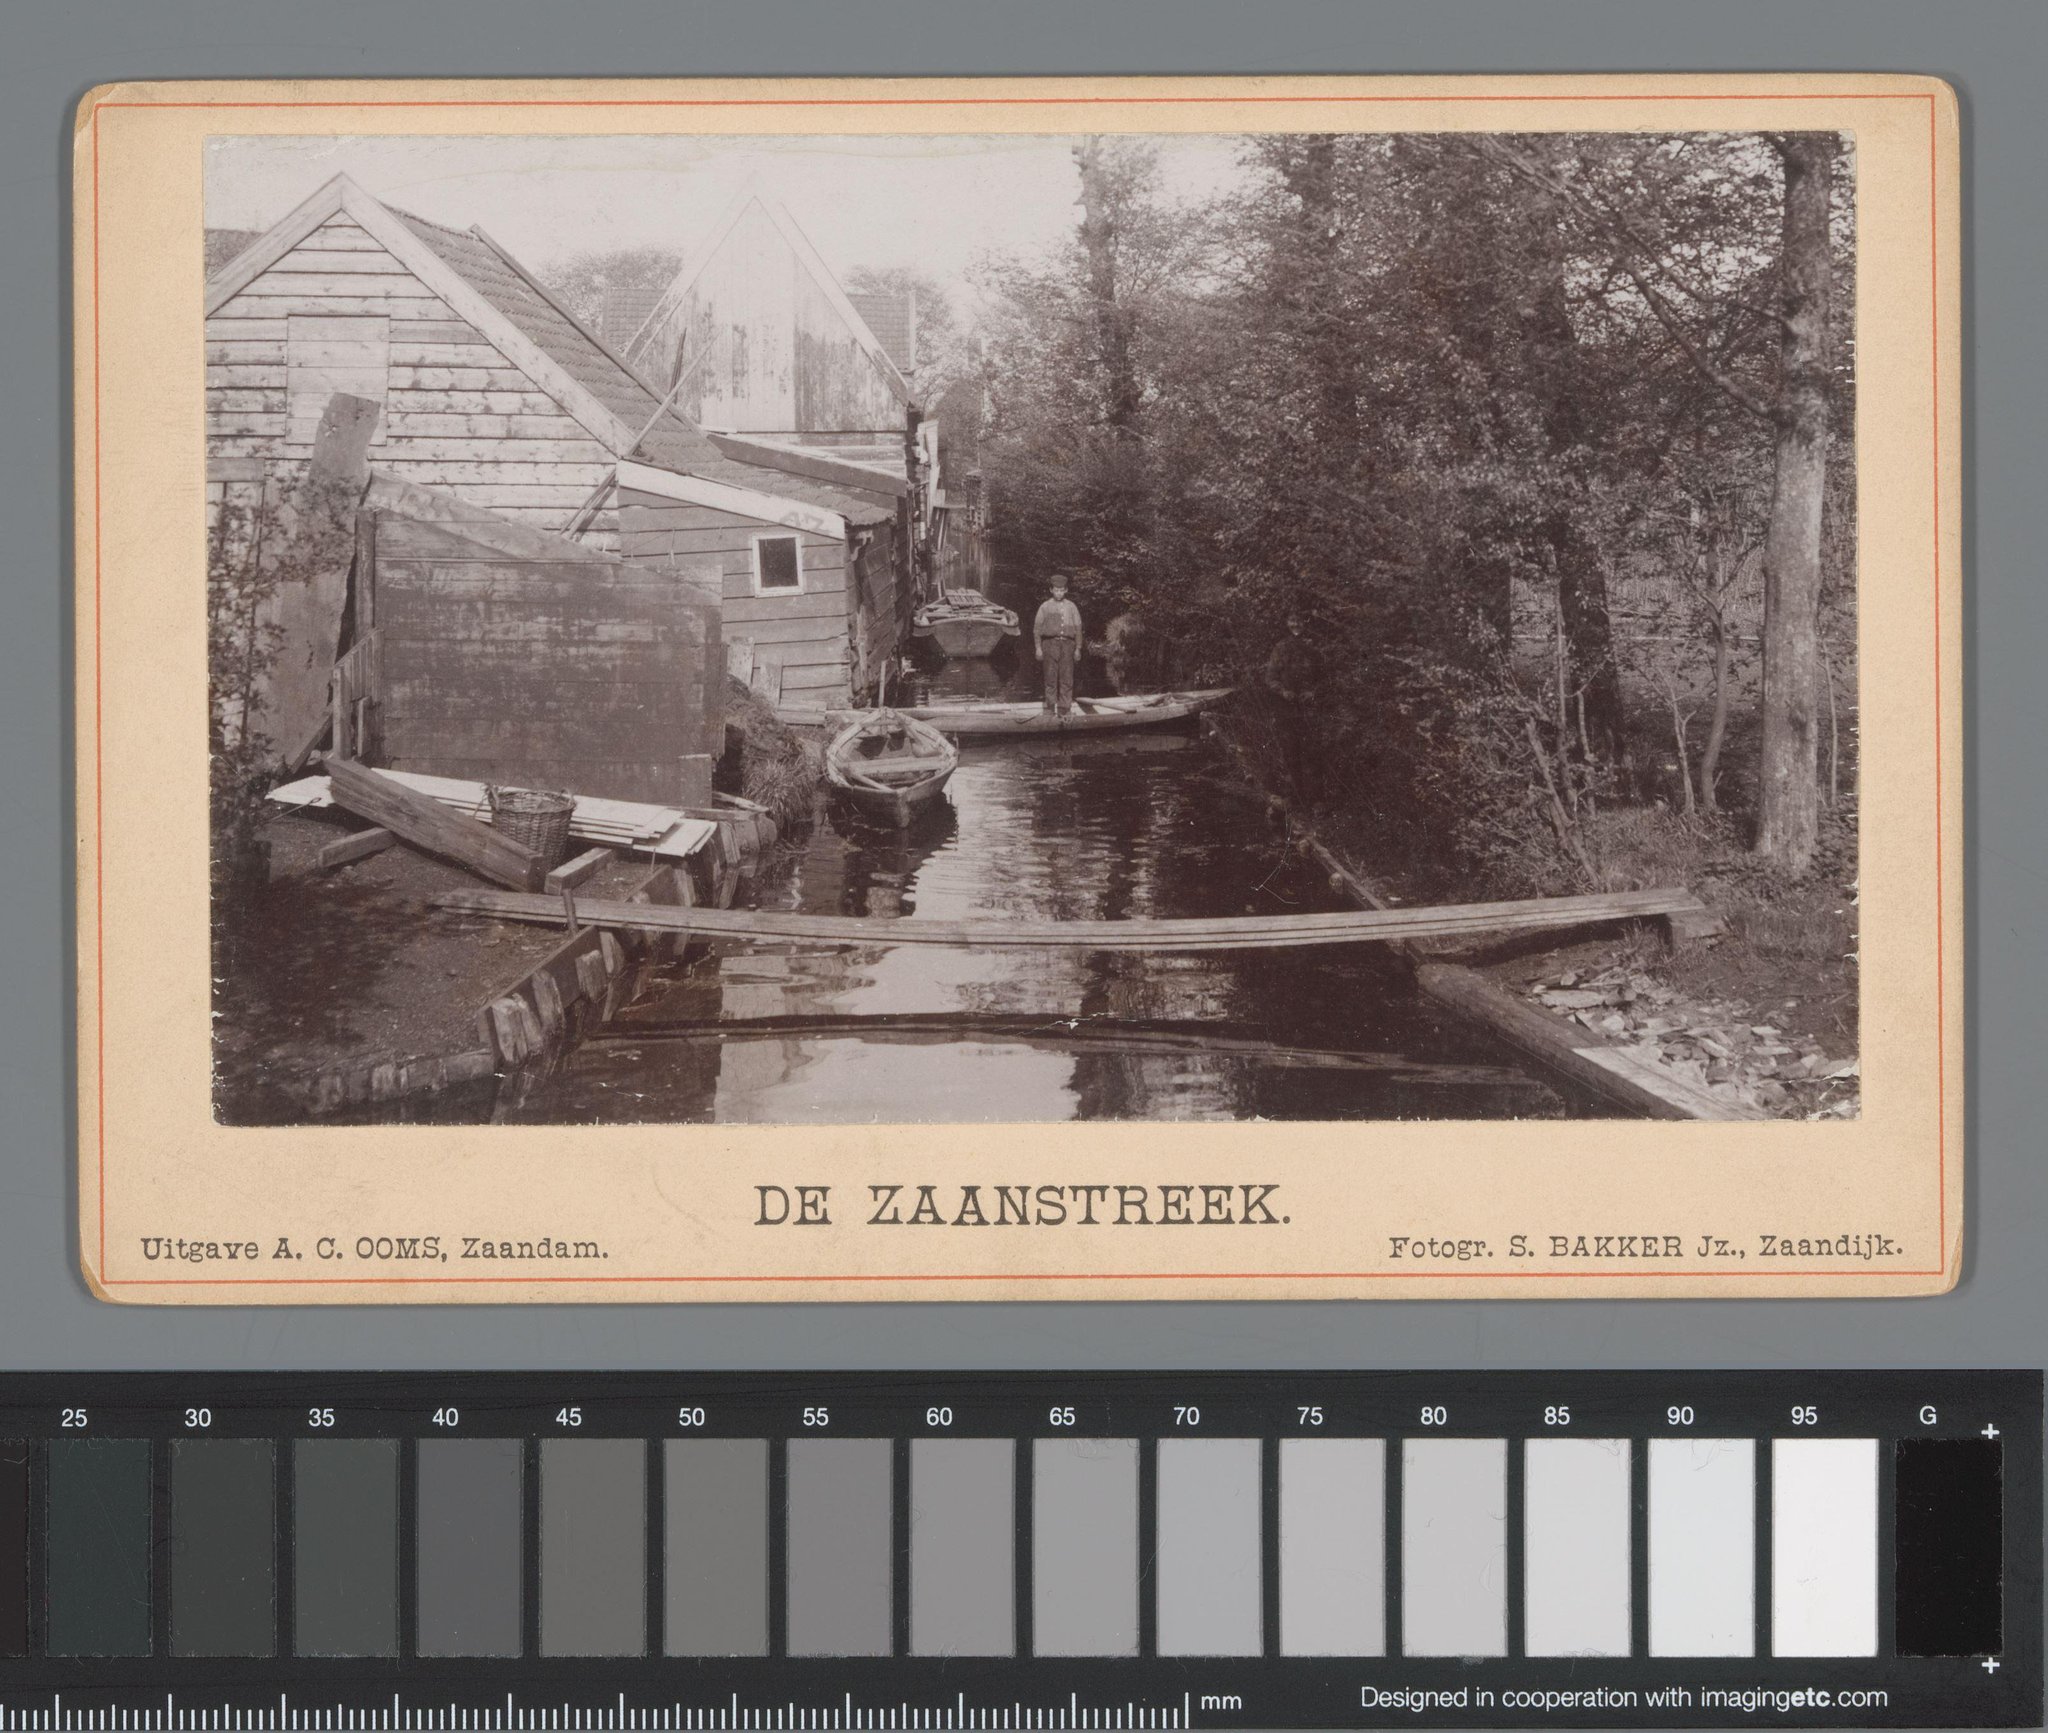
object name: photograph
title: Sloot met huizen te Zaandam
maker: simon bakker jz.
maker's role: printer, publisher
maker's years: 1873-1930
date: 1890-1910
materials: cardboard, photographic support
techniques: collodion silver print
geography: zaandam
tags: housing, small canal, ditch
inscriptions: annotation: ‘Zaandam’, inscription: ‘De Zaanstreek’